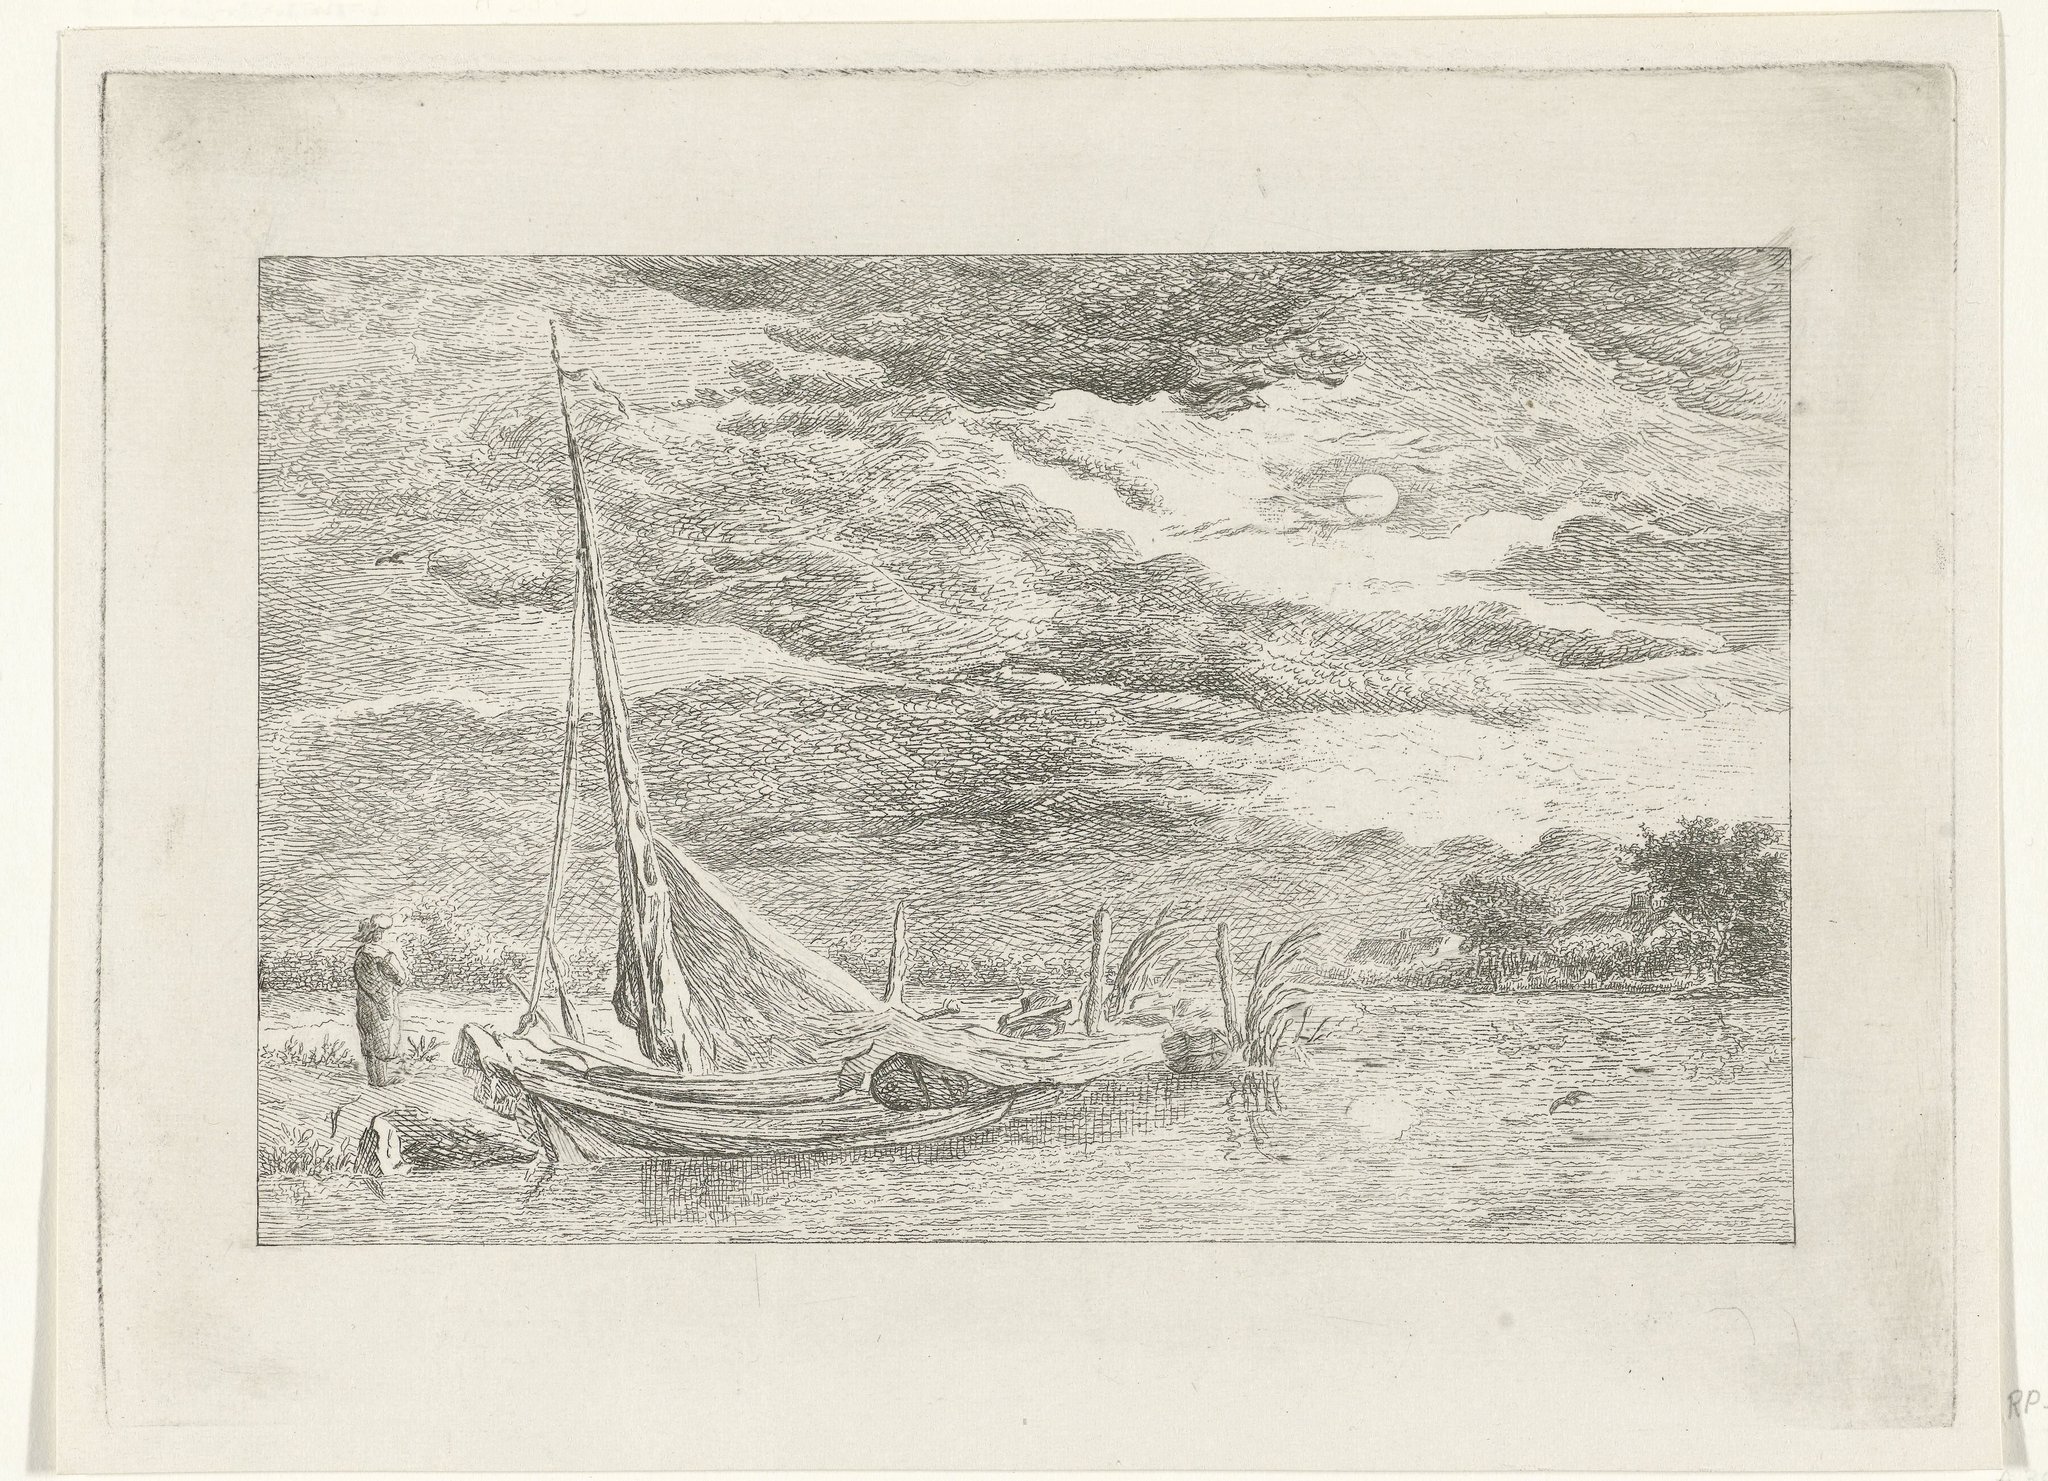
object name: print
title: Water bij maneschijn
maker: reinierus albertus ludovicus baron van isendoorn à blois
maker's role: print maker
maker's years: 1786-1856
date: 1796-1856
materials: paper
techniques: etching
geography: vaassen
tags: sailing-ship, sailing-boat, moonlight, landscapes with waters, waterscapes, seascapes (in the temperate zone)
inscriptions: collector's mark: Lugt 2228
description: Water bij maneschijn. Links staat een man op de oever bij een zeilschip met gestreken zeil.